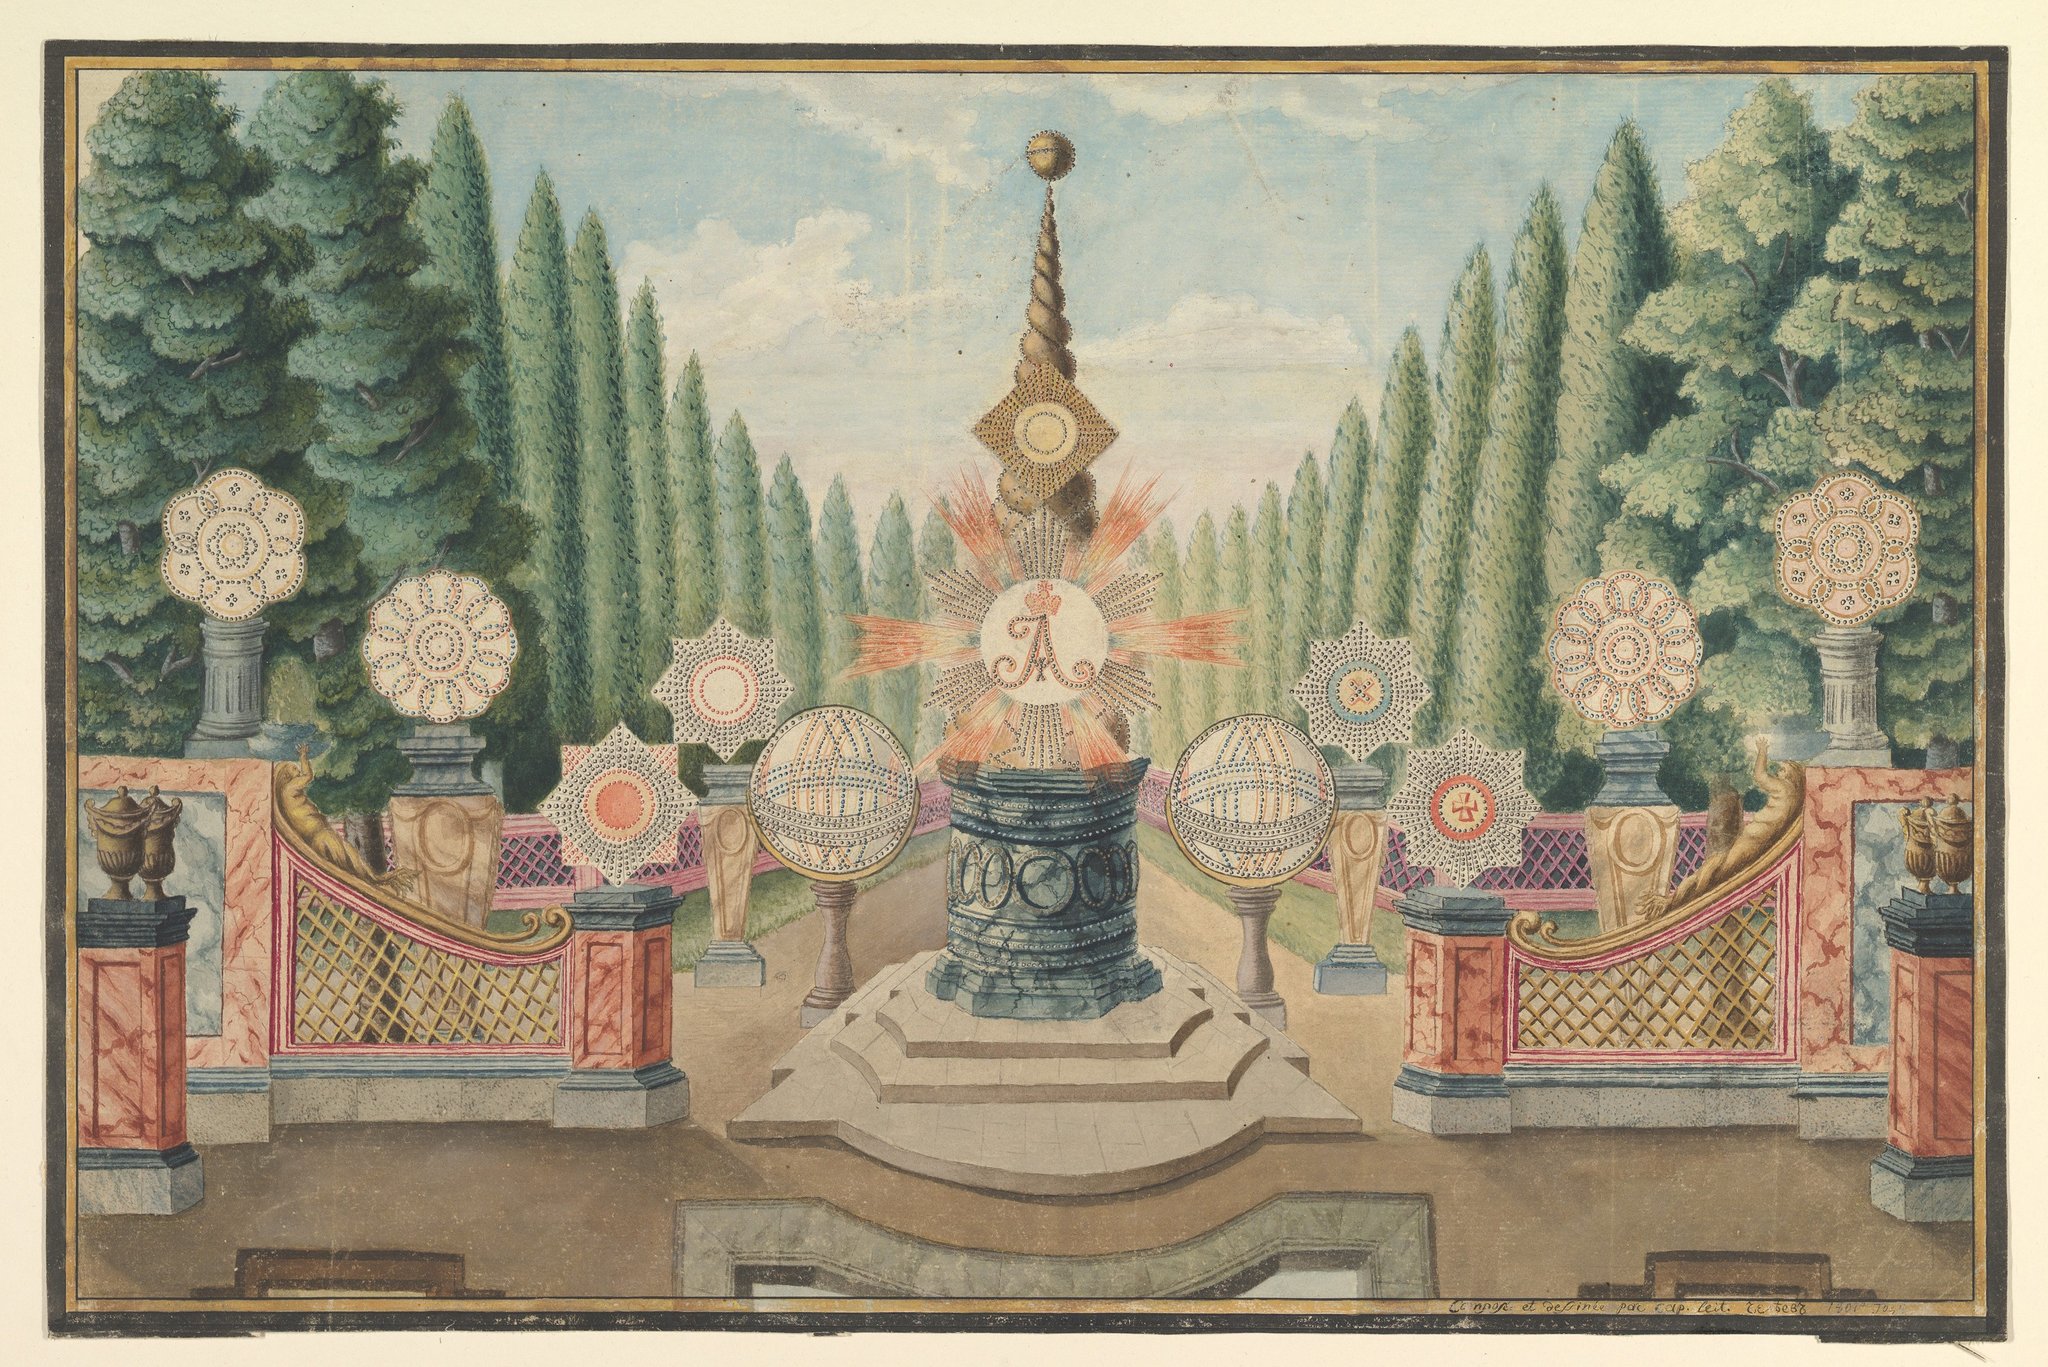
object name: drawing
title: Coronation of the Czar Alexander I, Moscow, September 1801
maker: lieutenant-captain cheleyev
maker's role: artist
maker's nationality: russian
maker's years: 19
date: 1801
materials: watercolor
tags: trees,insignia